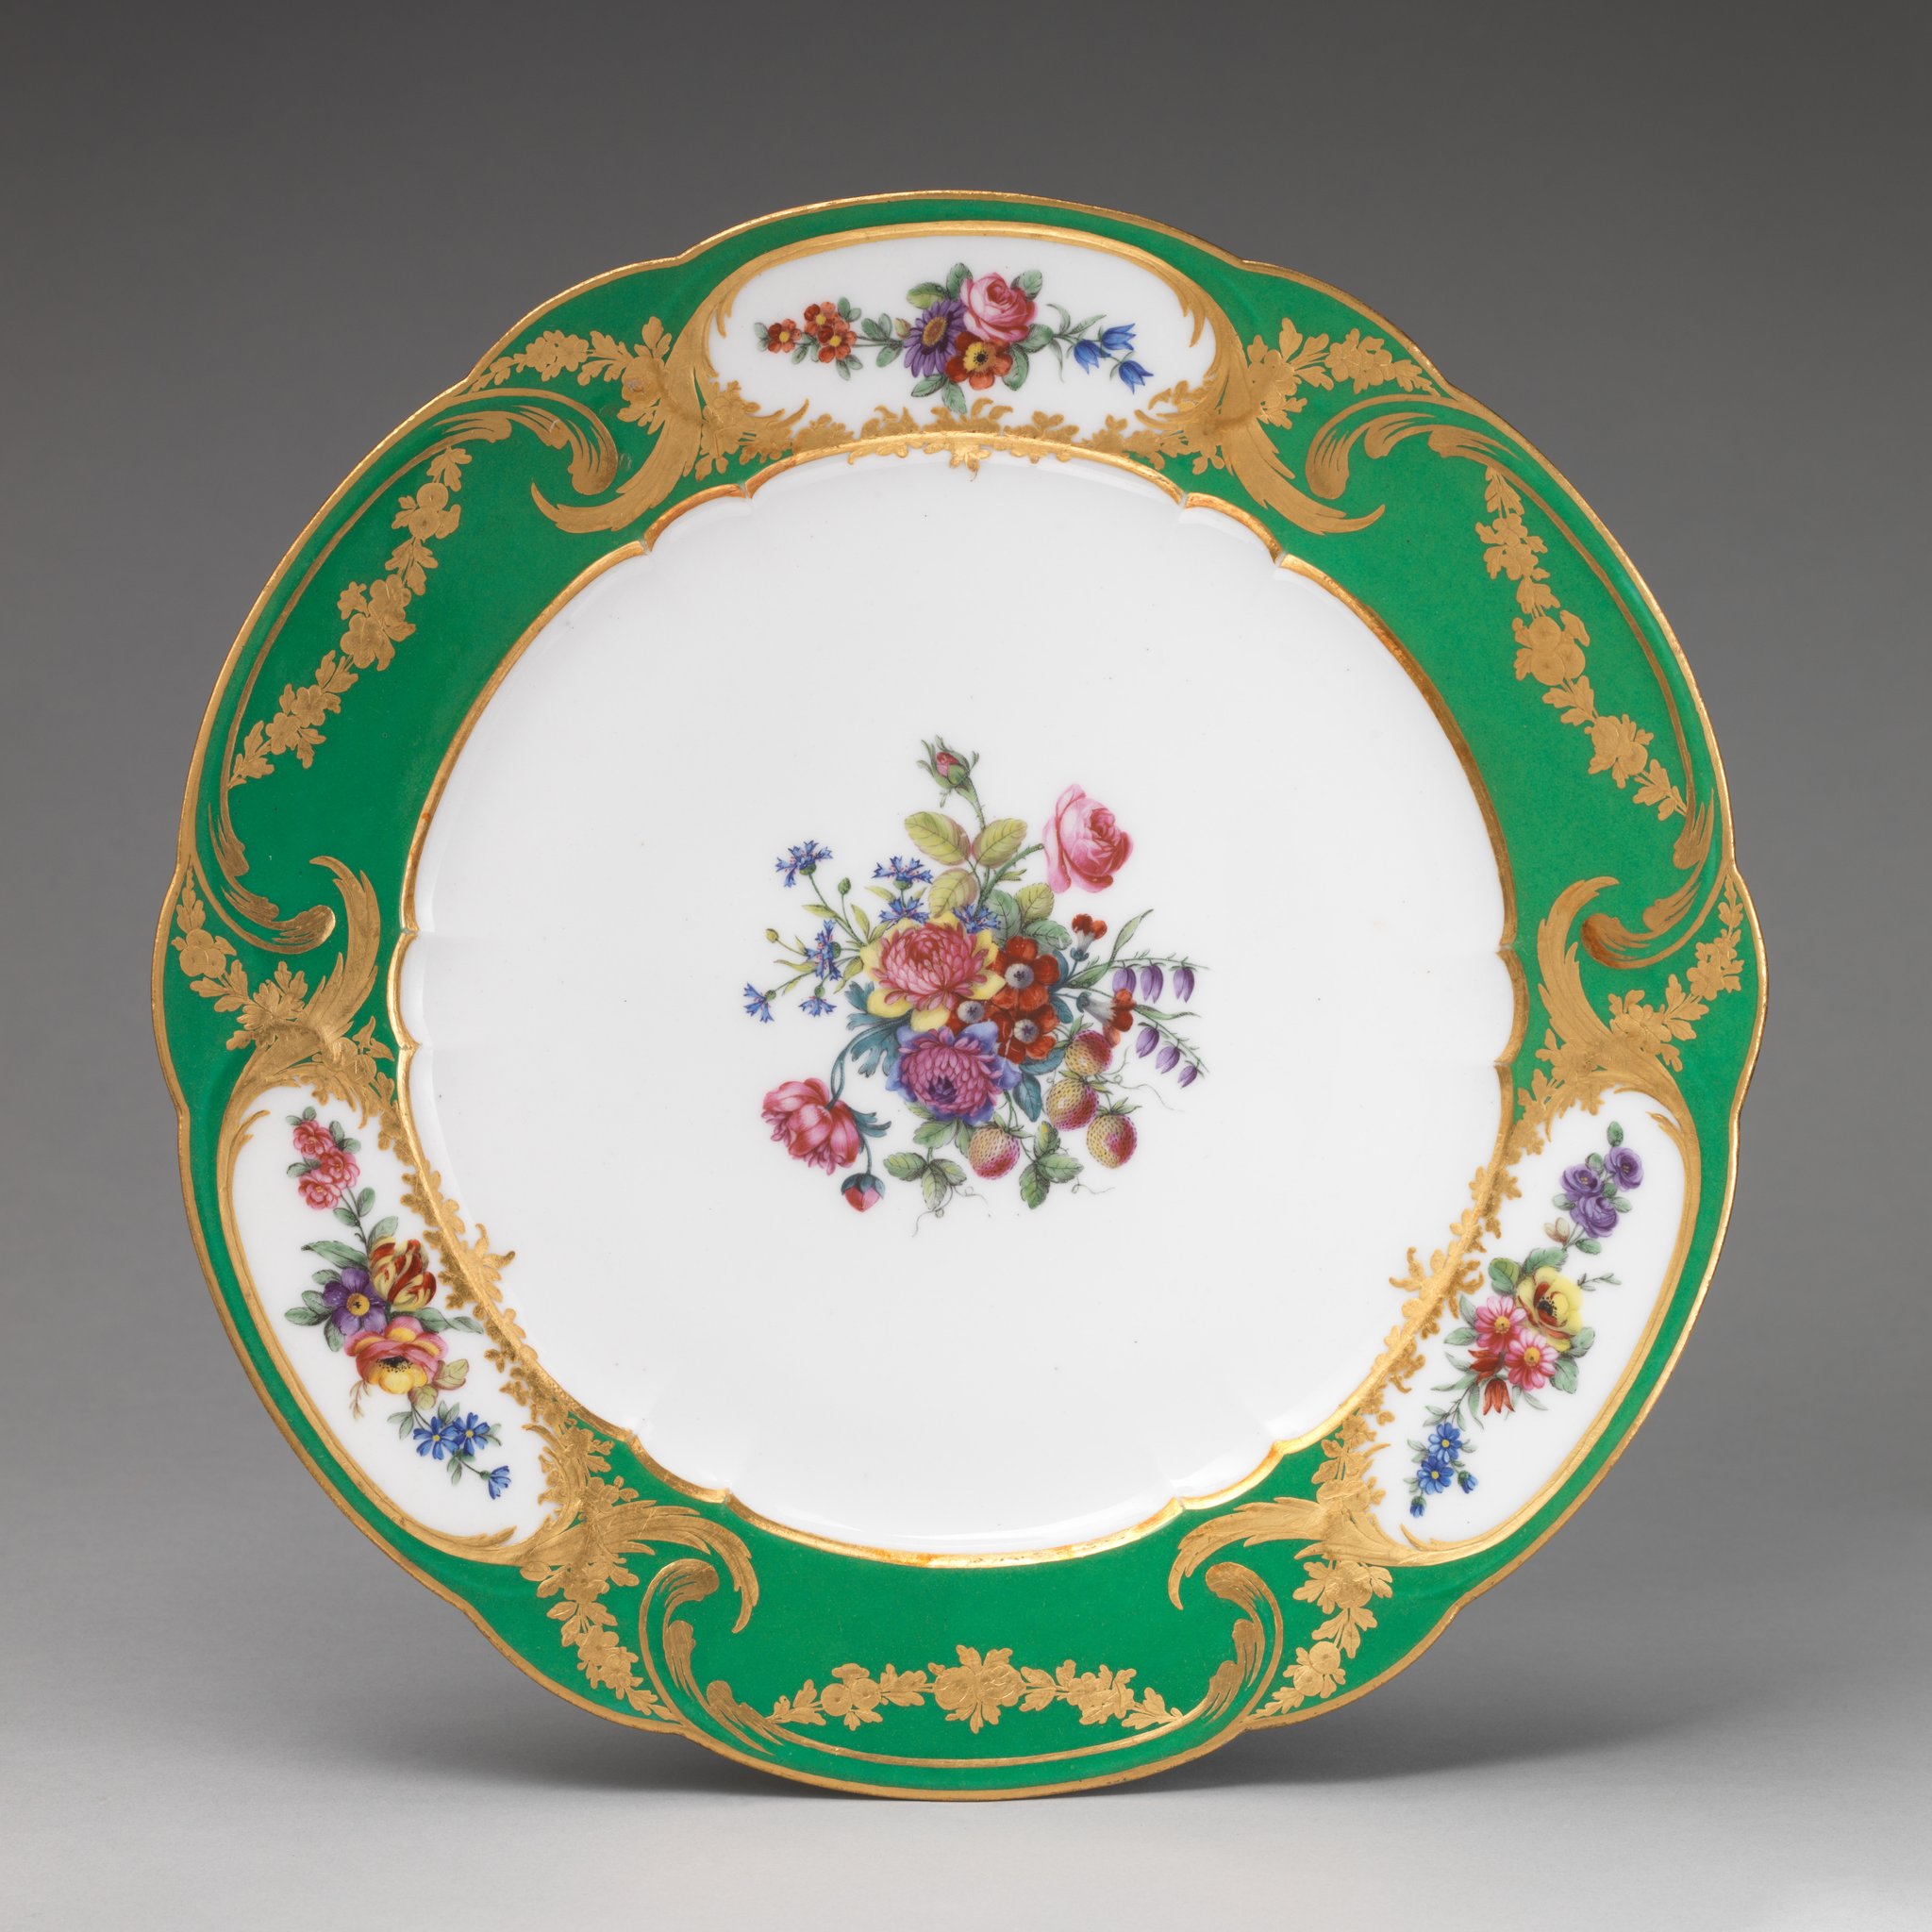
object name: plate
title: Plate (Assiette à palmes) (1 of 102) (part of a service)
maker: sèvres manufactory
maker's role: manufactory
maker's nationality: french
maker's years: 1740-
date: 1780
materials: soft paste porcelain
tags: flowers